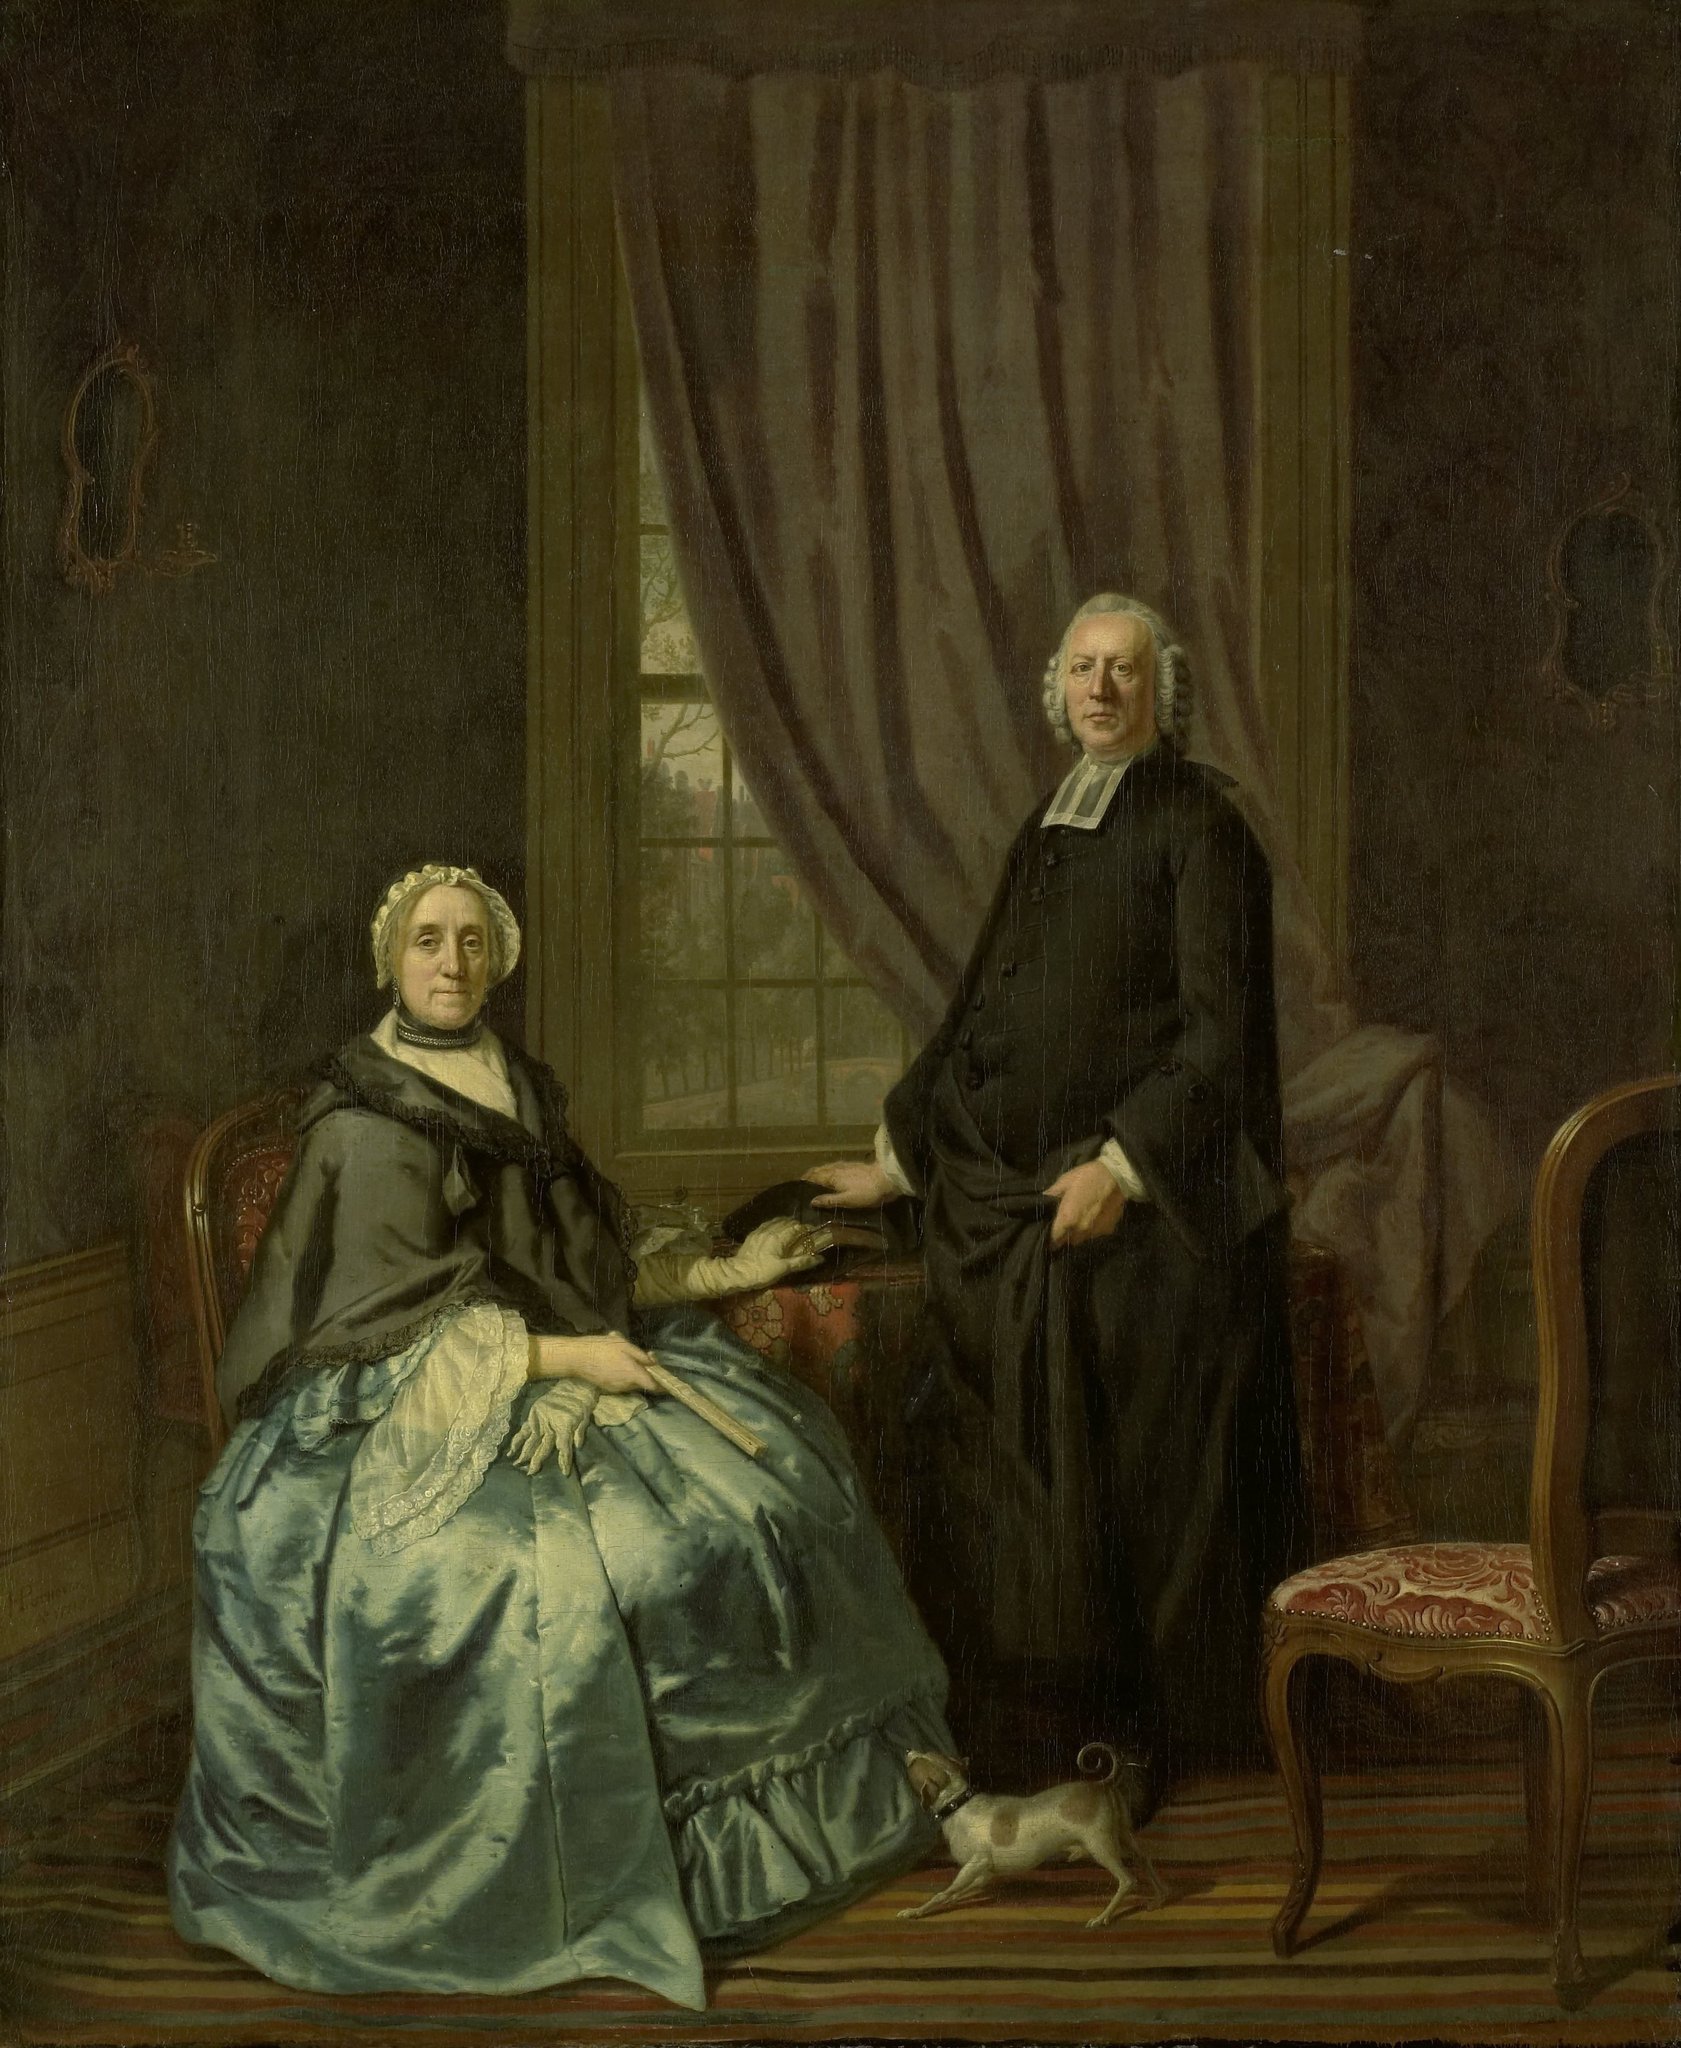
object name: painting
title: Portrait of Petrus Bliek, Remonstrant Minister in Amsterdam, with his Wife Cornelia Drost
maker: hendrik pothoven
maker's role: draughtsman, painter, print maker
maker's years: 1725-1807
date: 1771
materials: canvas, oil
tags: functionaries and dignitaries (with name) ~ protestant churches, historical persons - bb - woman, historical persons, marriage, married couple, 'matrimonium'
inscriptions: signature and date: ‘HPothoven f. Aº 1771’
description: Portret van Petrus Bliek (1706-97), remonstrants predikant te Amsterdam, met zijn vrouw Cornelia Drost (gest. 1775). In een interieur voor een grote venster met uitzicht op een gracht. Links zit Cornelia op een stoel aan een tafel, waaier en handschoen in de rechterhand, een boek in de linkerhand. Bij haar voeten een hondje. Petrus staat rechts naast de tafel, met zijn linkerhand tilt hij zijn toga iets op. Aan de muur twee wandblakers met spiegel.